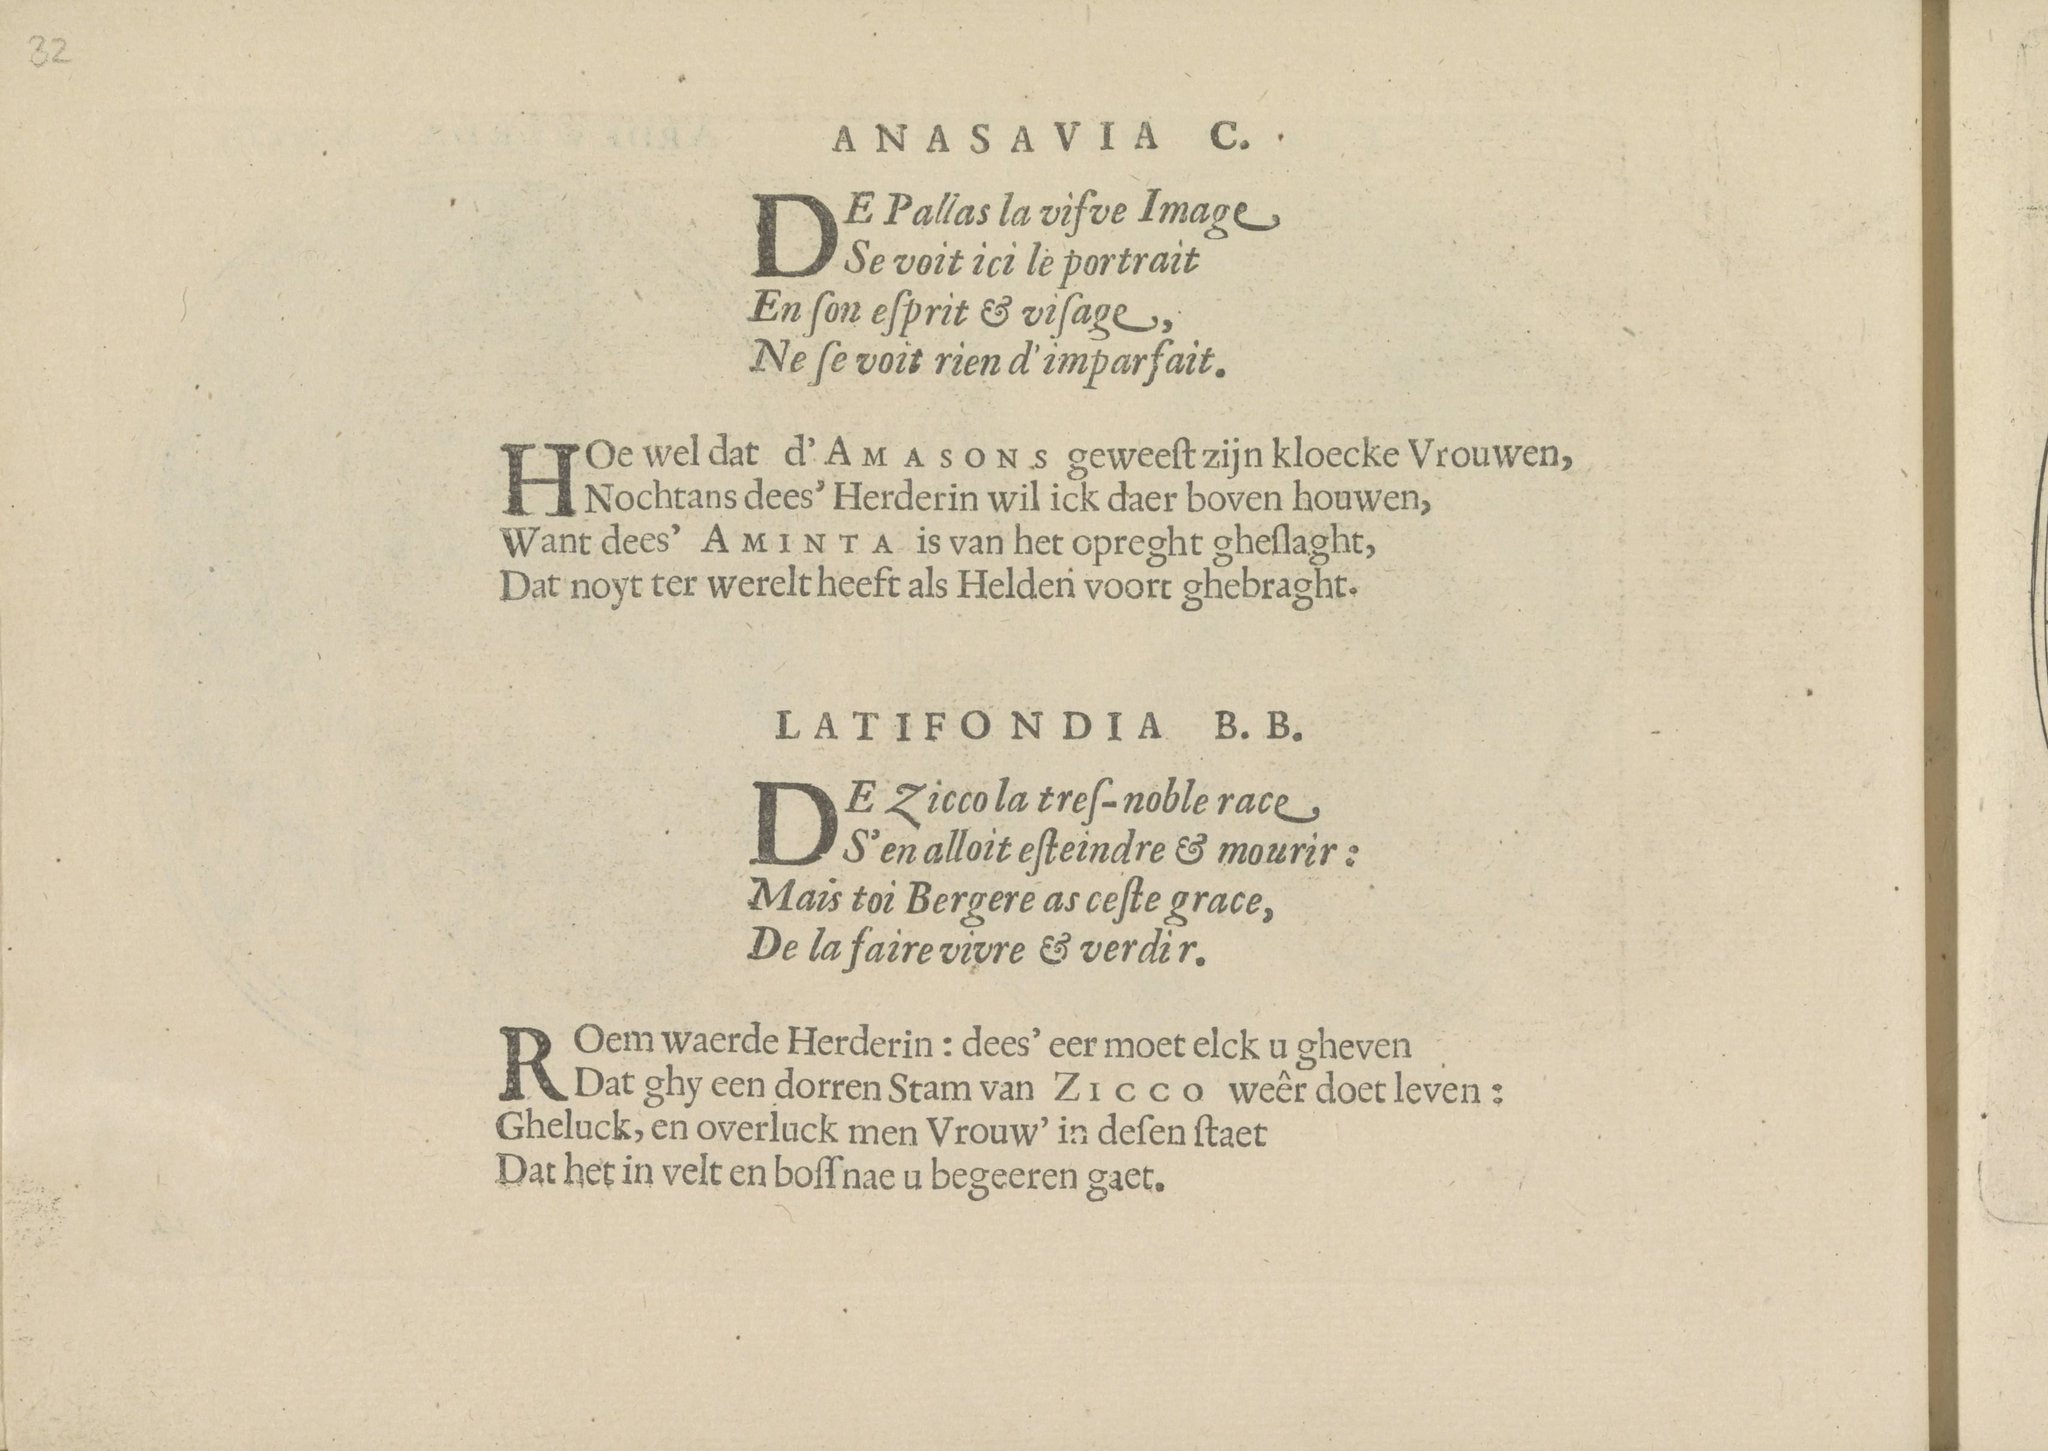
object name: text sheet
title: Les vrais pourtraits de quelques unes des plus grandes dames de la chrestiente desguisees en bergeres.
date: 1640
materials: paper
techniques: letterpress printing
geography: amsterdam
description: Twee keer twee kwatrijnen in het Frans en Nederlands bij de voorstellingen van Anasavia C. en Latifondia B.B. Het blad maakt deel uit van een album.